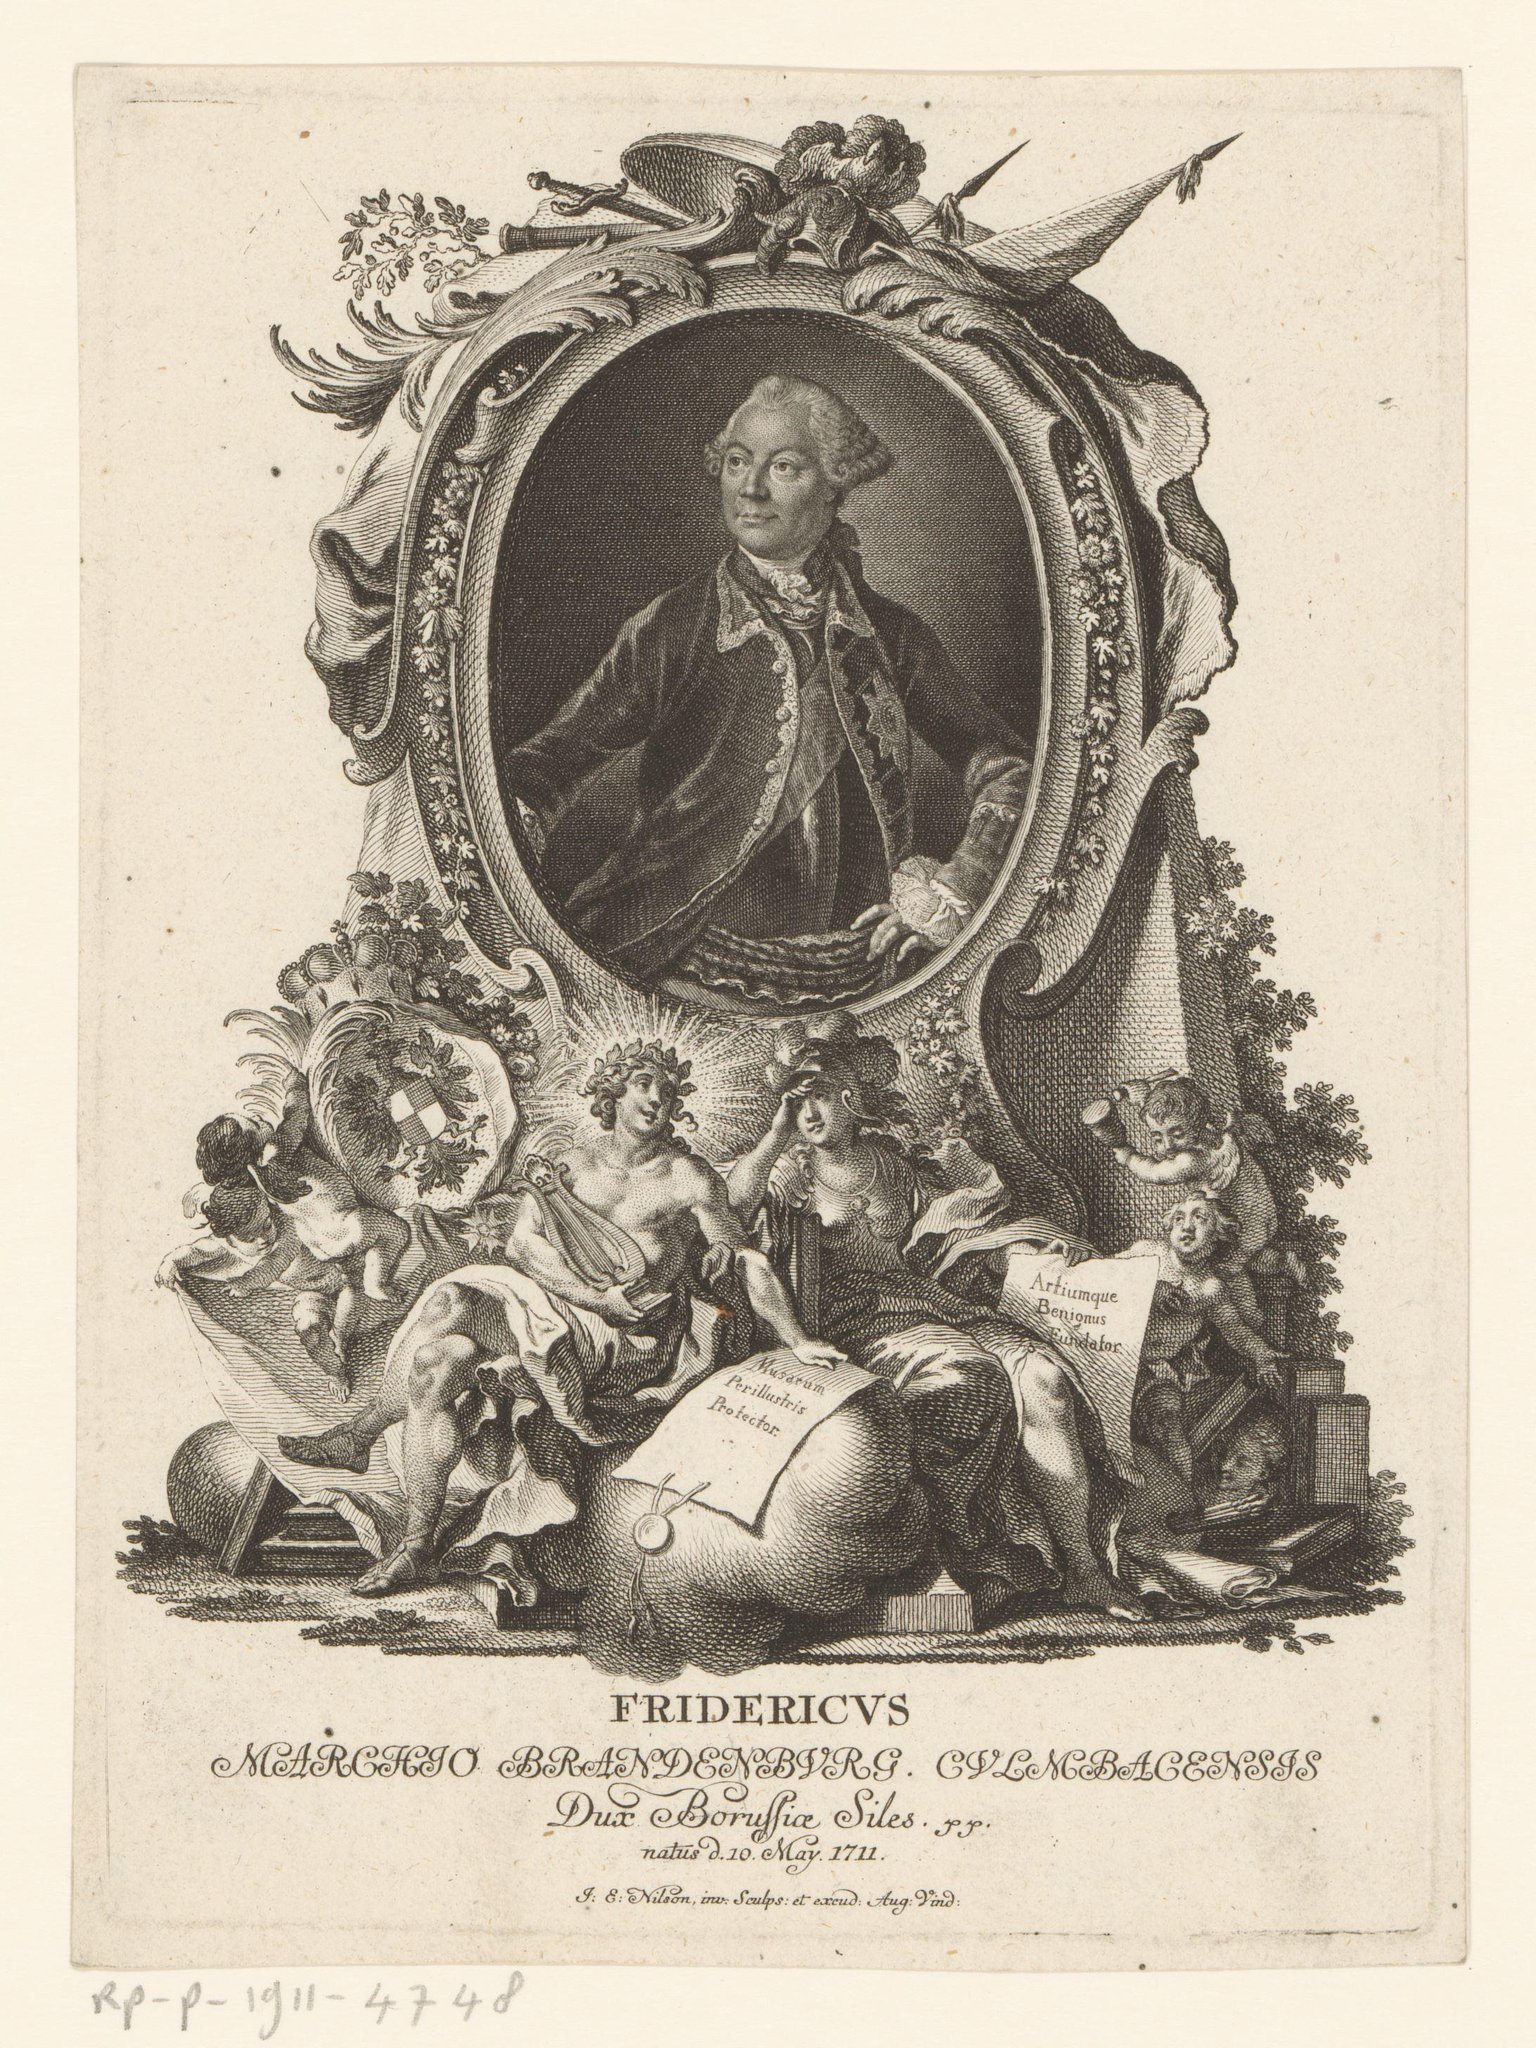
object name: print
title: Portret van Frederik III van Brandenburg-Bayreuth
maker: johann esaias nilson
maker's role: draughtsman, print maker, publisher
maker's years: 1721-1788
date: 1731-1788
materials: paper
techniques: engraving, etching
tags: 'musica', symbolic representations, allegories and emblems ~ music; 'musica'(ripa), historical persons, weapons, attributes of minerva, armorial bearing, heraldry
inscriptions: collector's mark: Lugt 2228